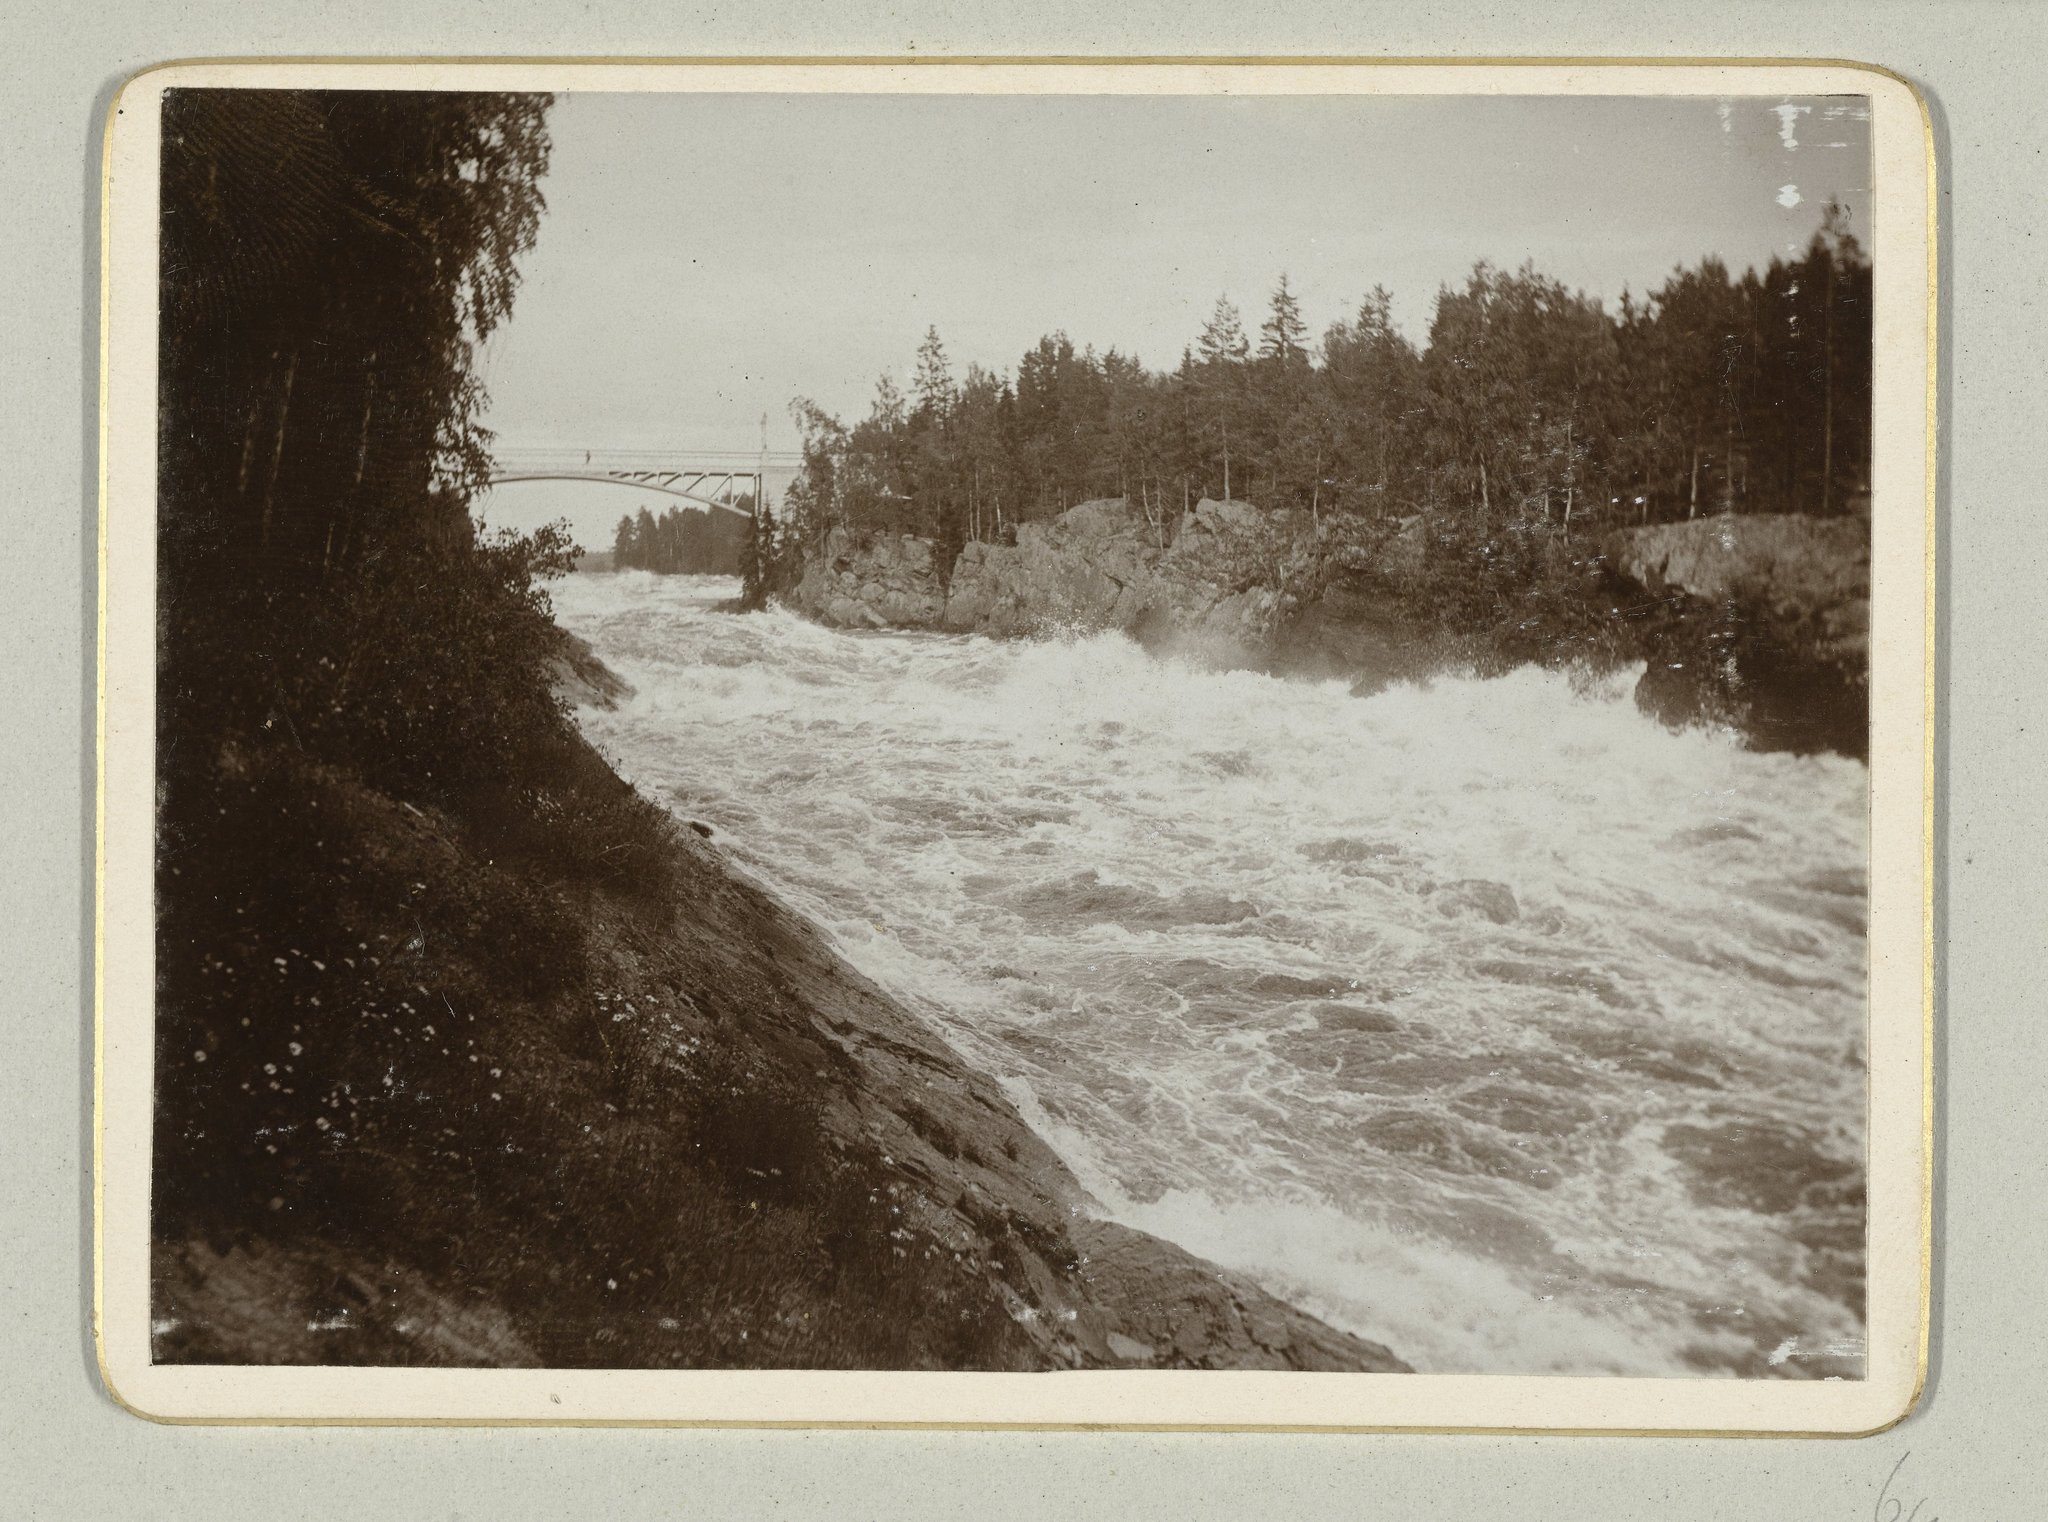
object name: photograph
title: Stroomversnelling van Imatra in Finland.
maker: henry pauw van wieldrecht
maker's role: fotograaf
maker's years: 1863-1912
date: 1898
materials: paper, photographic support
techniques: albumen print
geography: helsinki